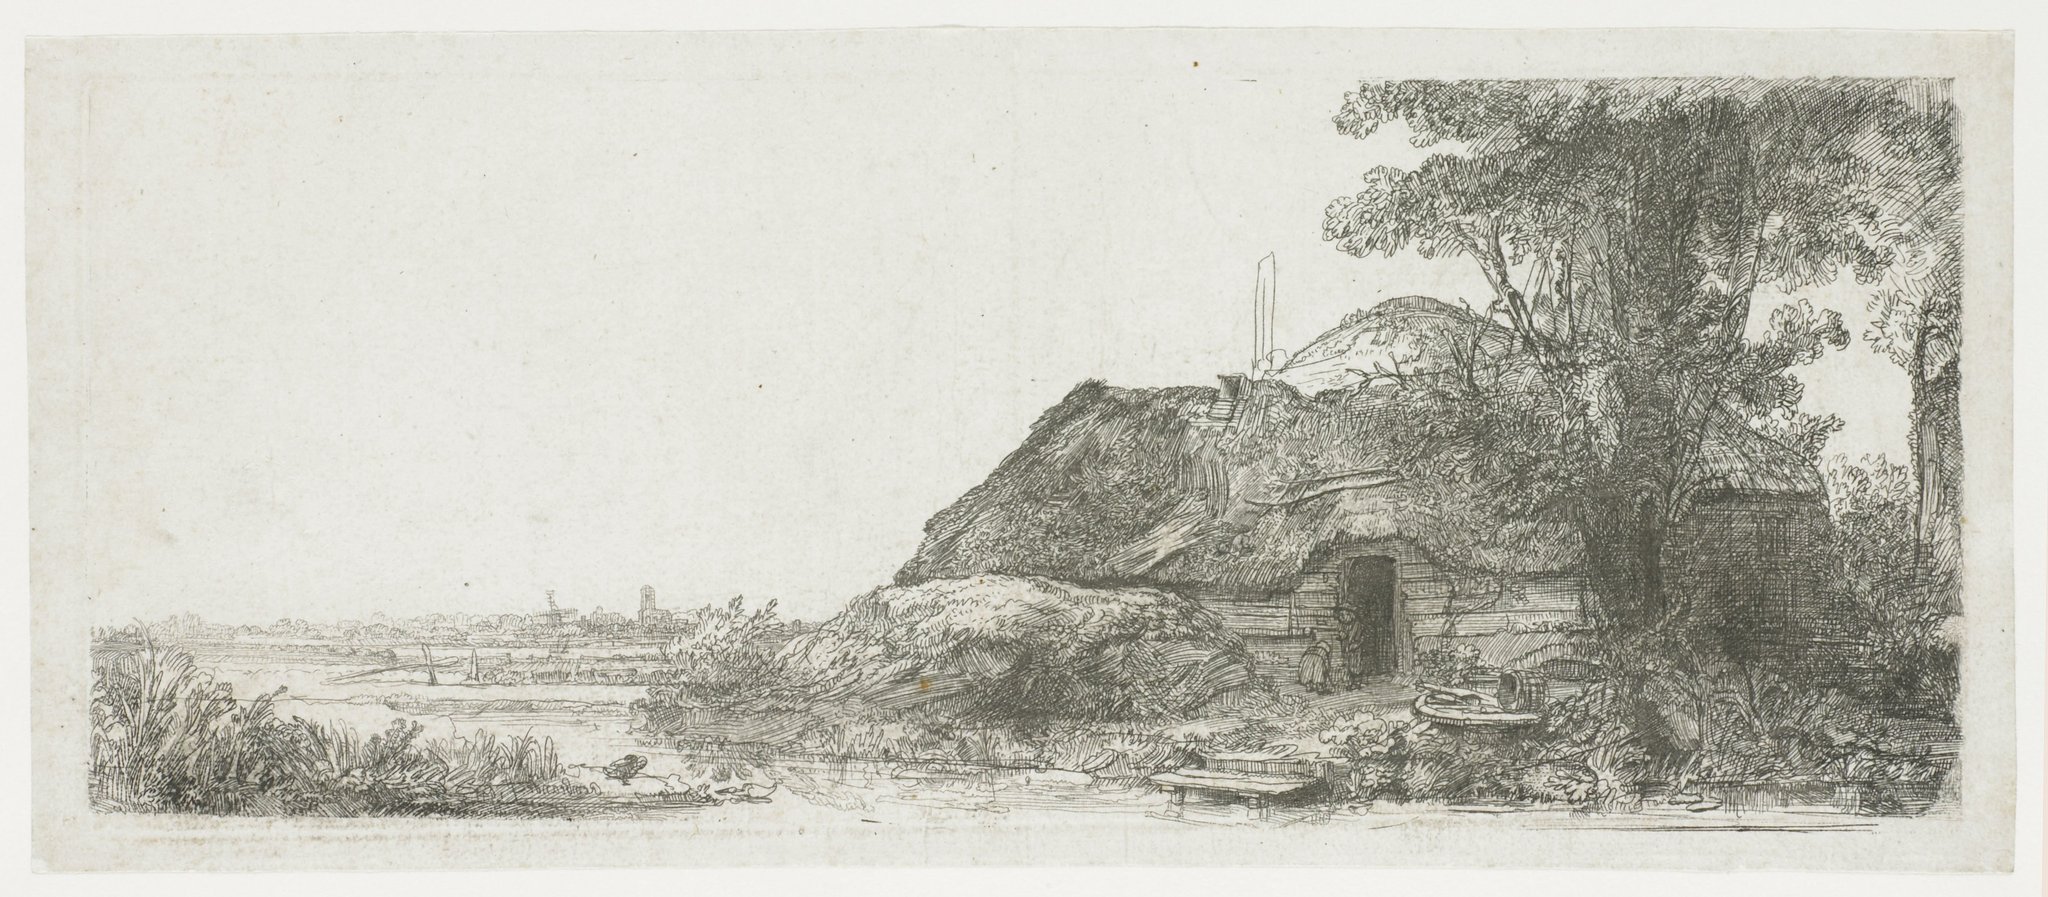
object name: print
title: Landscape with a cottage and a large tree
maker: rembrandt van rijn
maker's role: draughtsman, painter, print maker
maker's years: 1606-1669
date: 1641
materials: paper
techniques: printmaking, etching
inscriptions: signature and date: ‘Rembrandt f 1641 (spiegelbeeldig)’ Lugt, mark: 2228